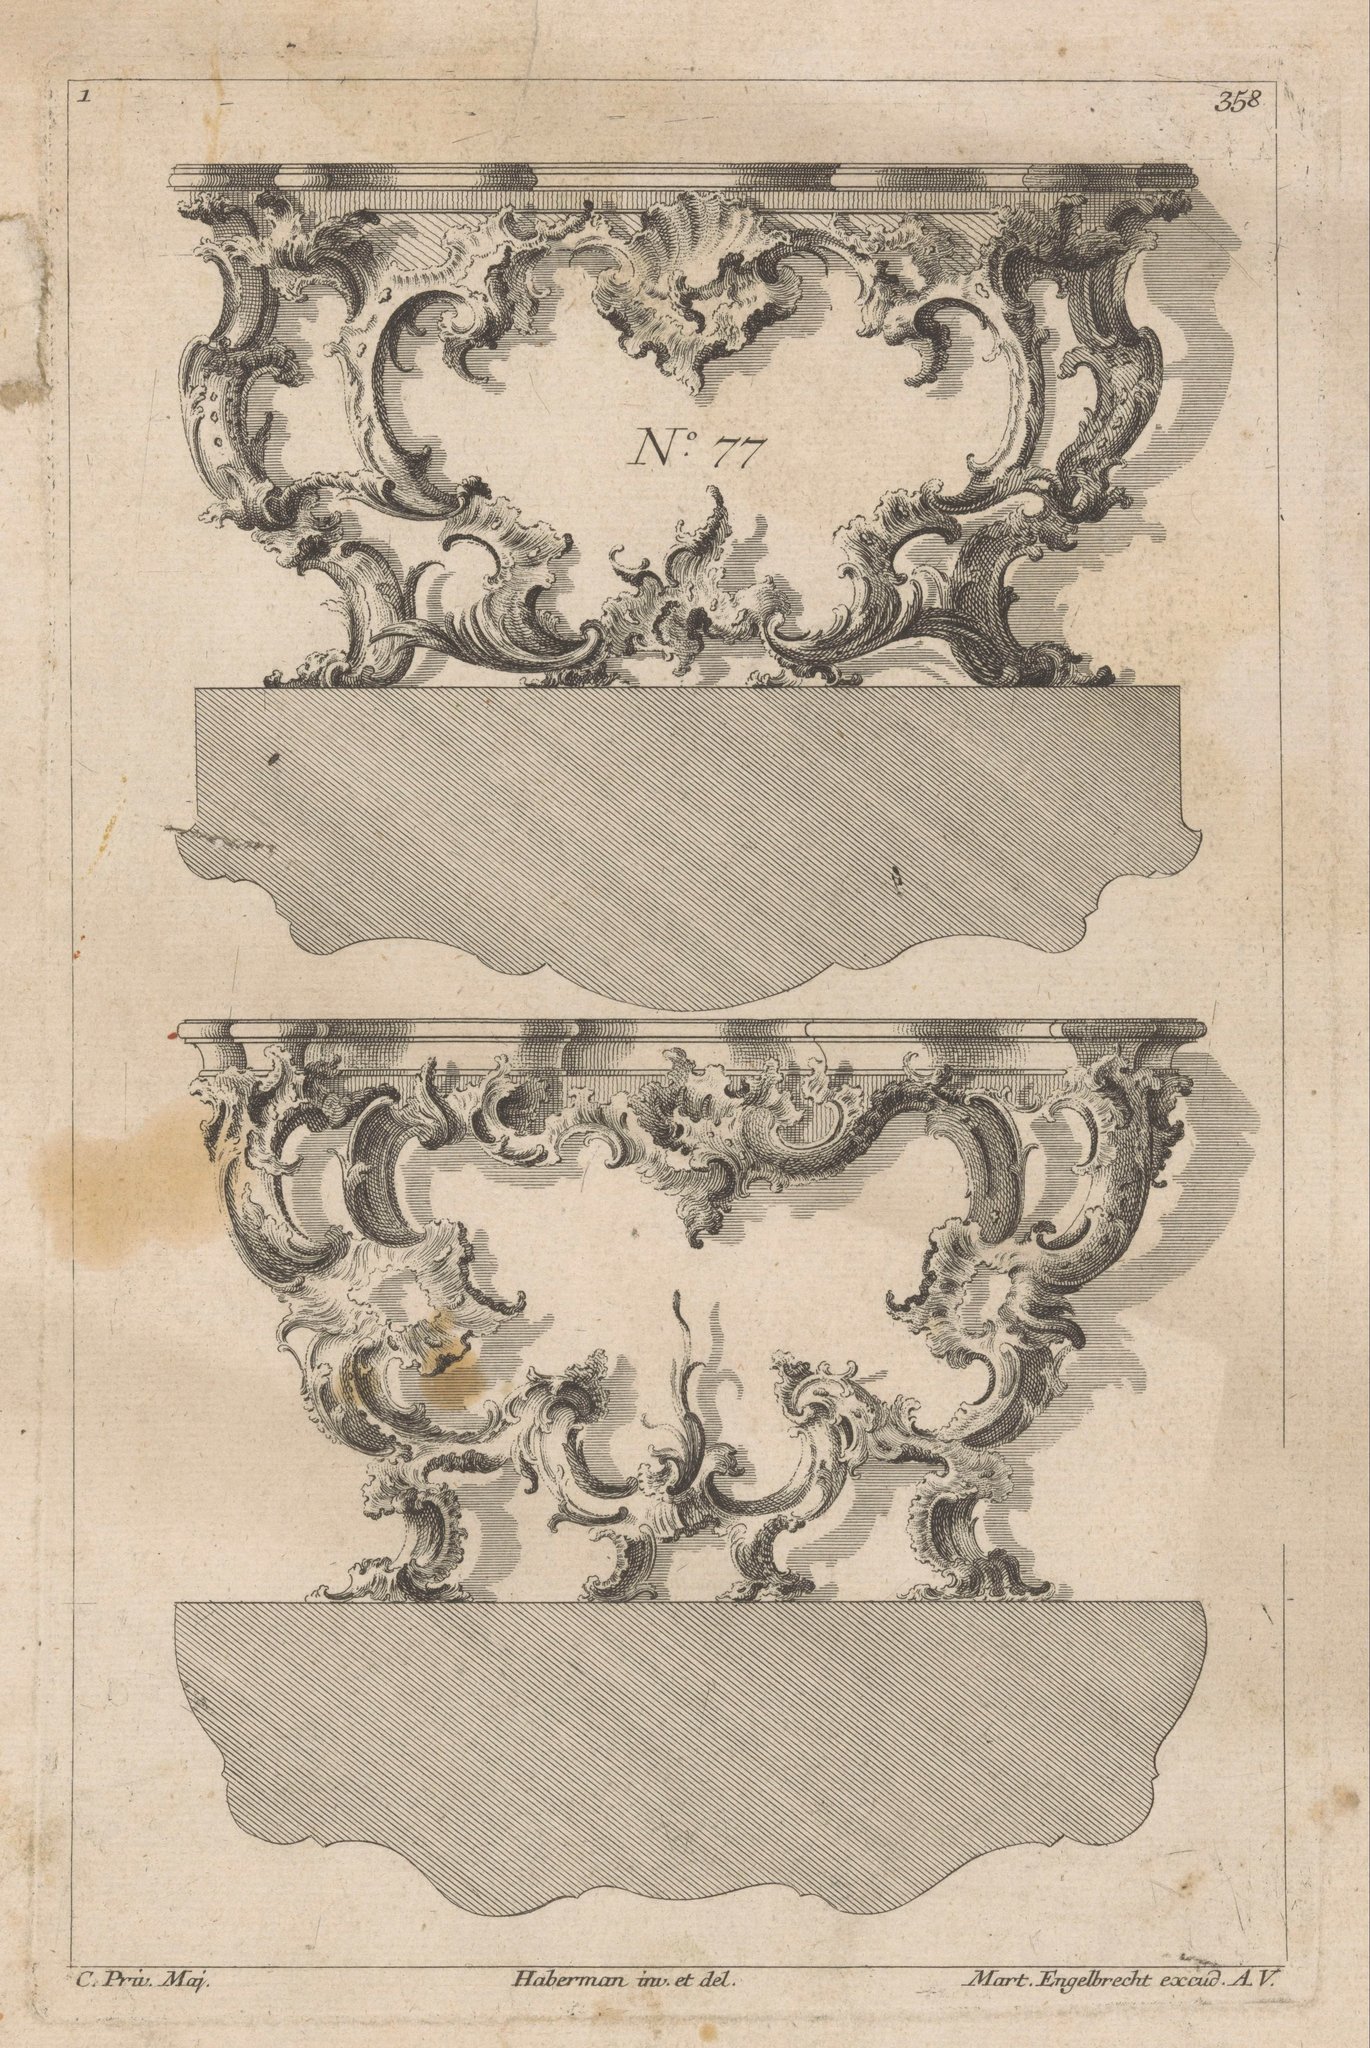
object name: print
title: Wandtafels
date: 1731-1756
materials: paper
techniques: engraving, etching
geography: augsburg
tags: rocaille ornament, table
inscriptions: collector's mark: Lugt 2228, collector's mark: Lugt 2760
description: Voor-en bovenaanzicht van twee wandtafels met rocaille ornamenten. Prentnummer 358, uitgeversnummer 77.